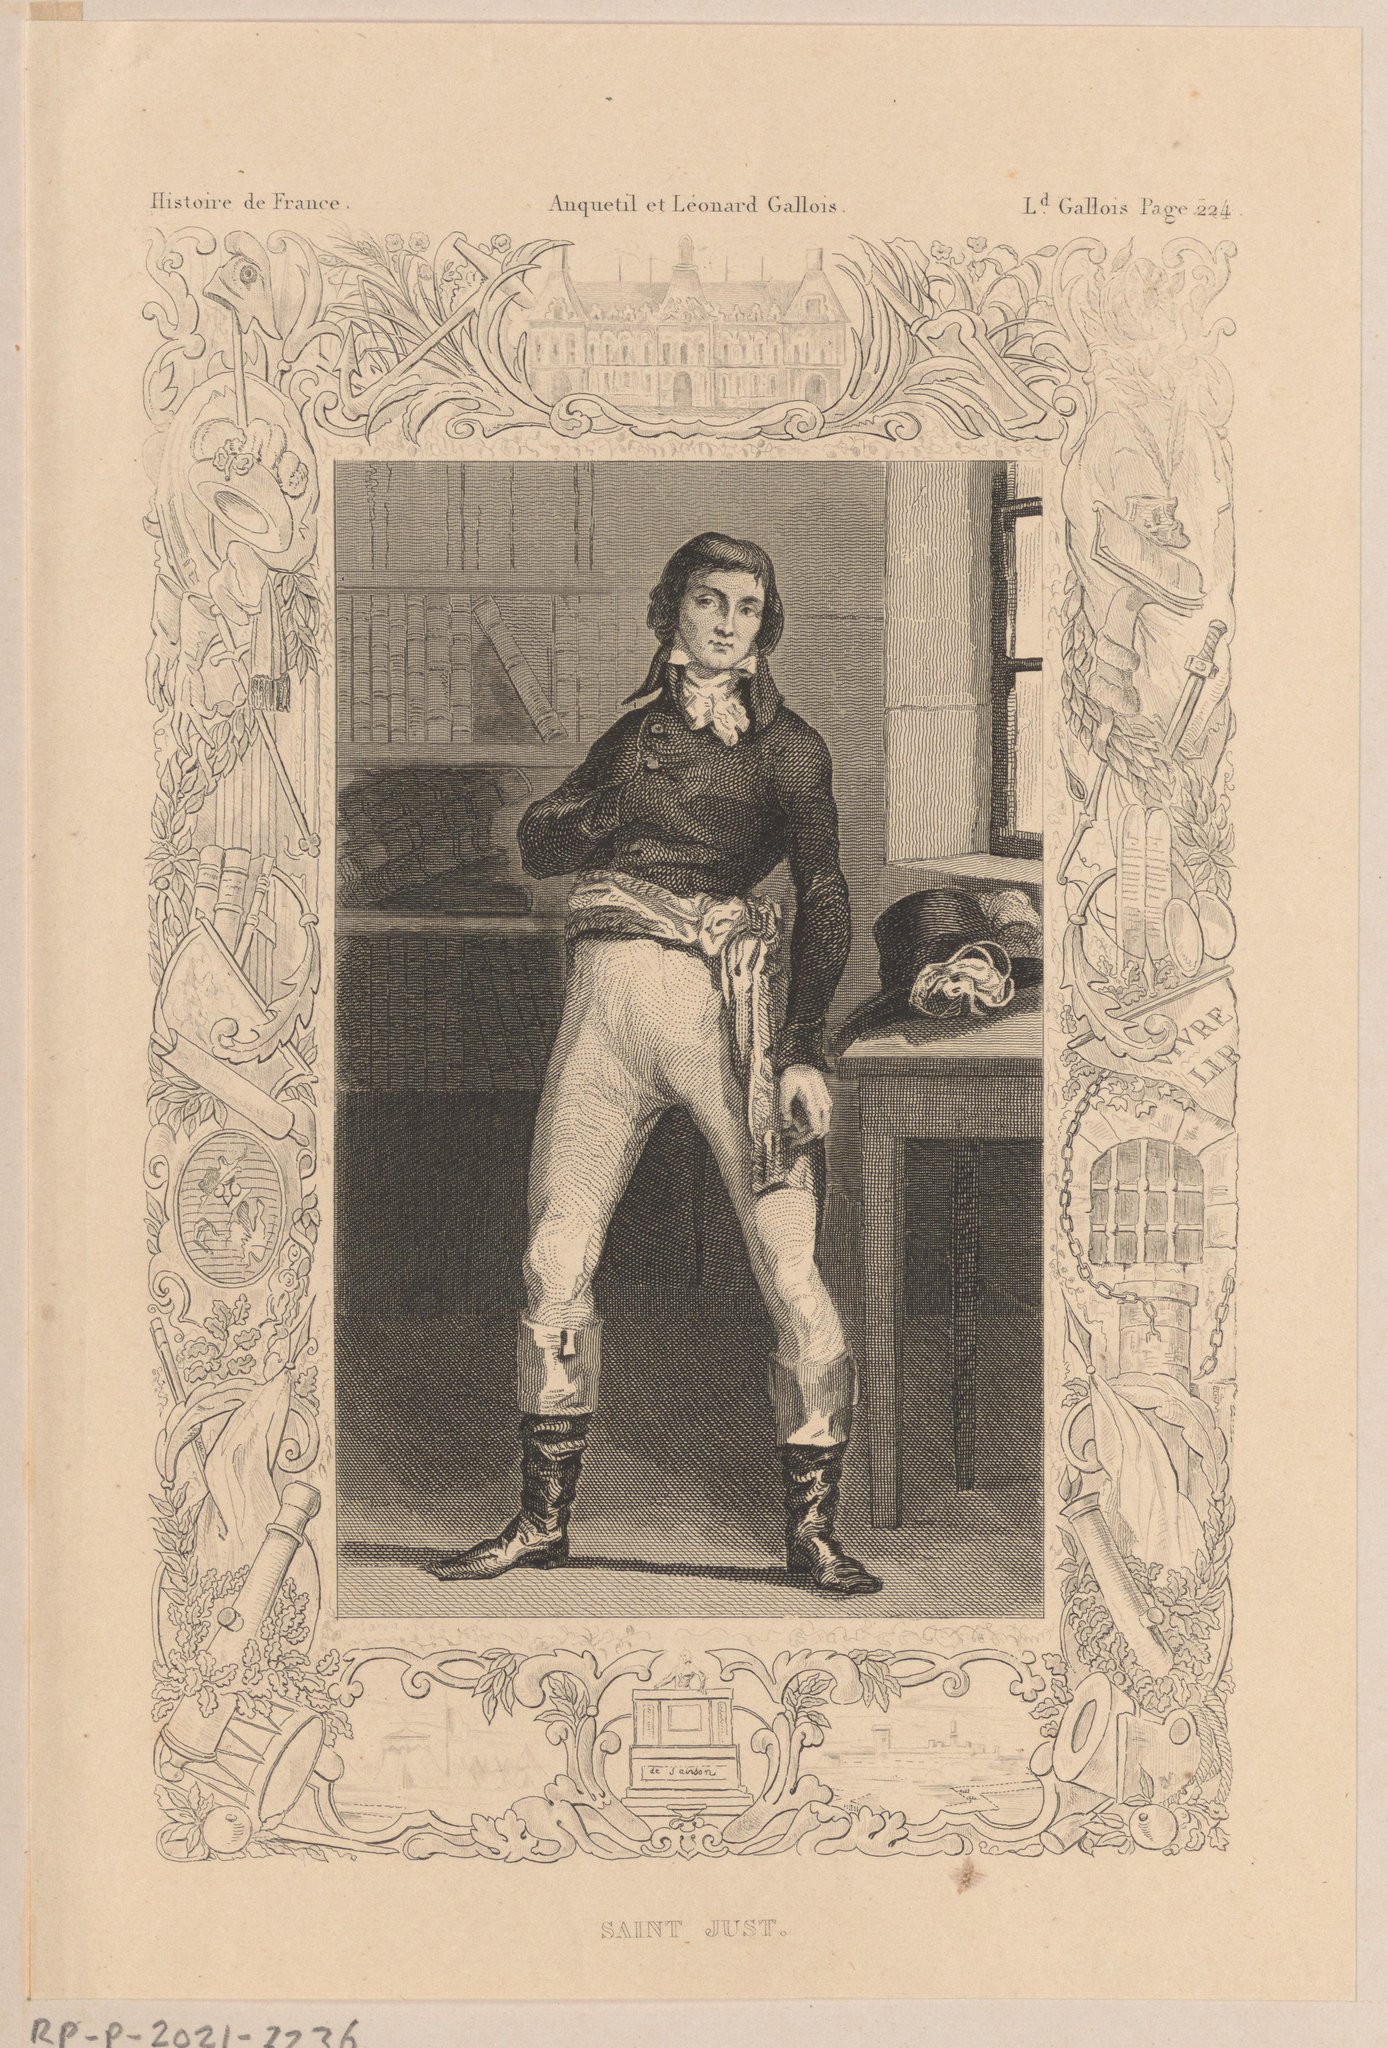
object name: print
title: Portret van Louis Antoine Leon de Saint-Just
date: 1845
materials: paper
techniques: etching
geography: paris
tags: paris, politician, historical persons, politician, e.g. party leader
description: Prent mogelijk uit: Anquetil, Louis Pierre, en Léonard Gallois. Histoire de France d'Anquetil, continuée depuis la Révolution de 1789 jusqu'à celle de 1830. 4 dln. Parijs: Au bureau central de l'histoire de France, 1845, dl. 3. Prent waarschijnlijk ook gebruikt in een eerdere editie.